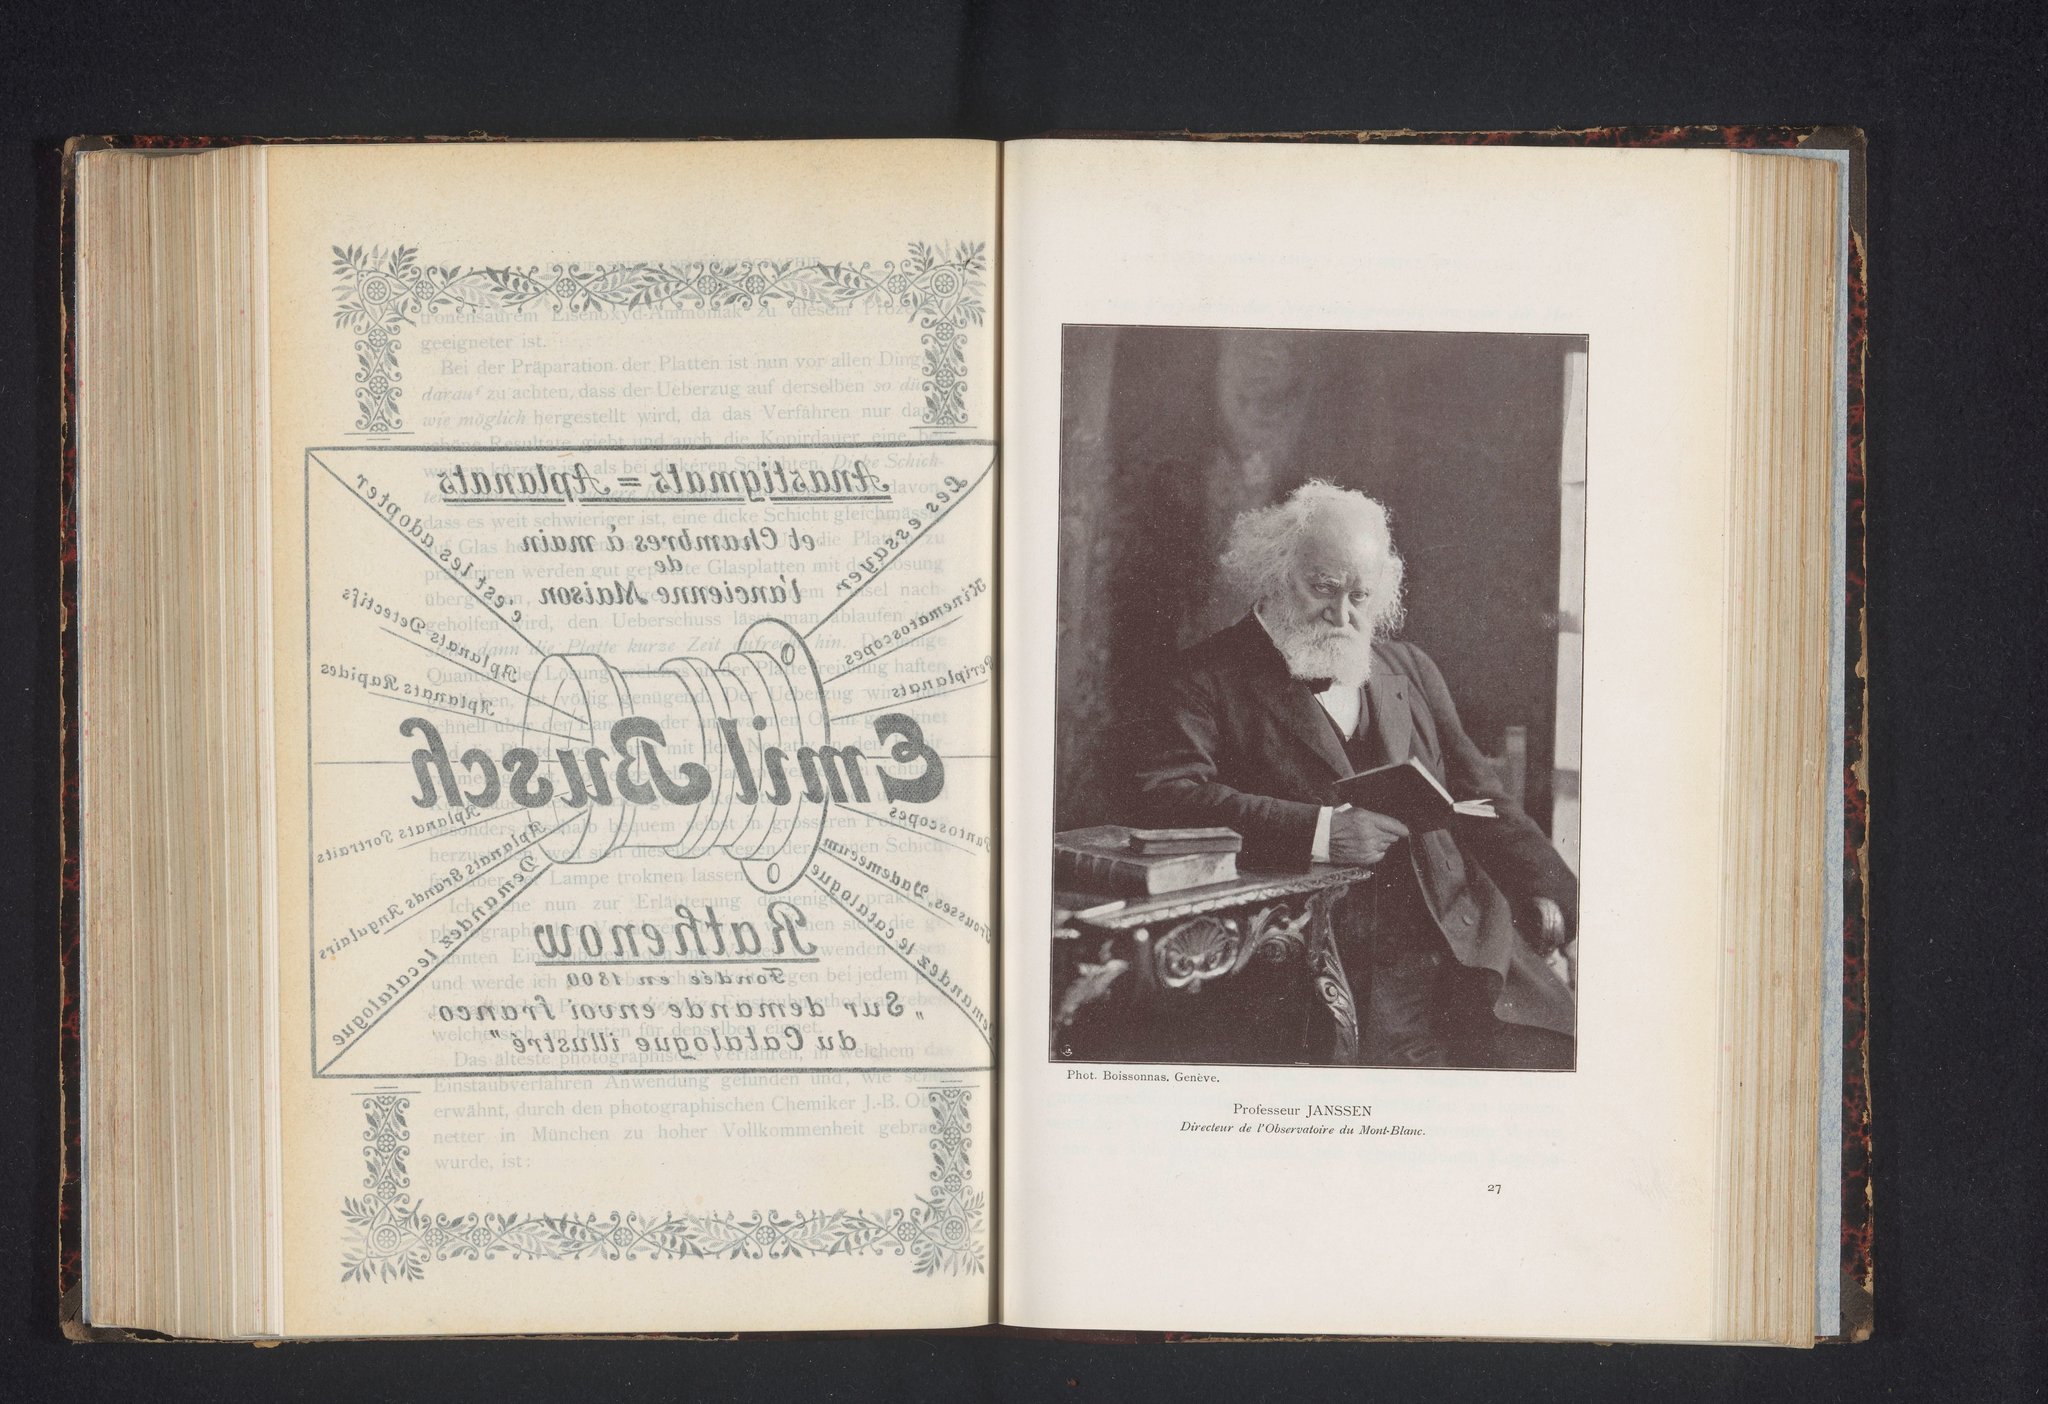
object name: page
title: Professeur Janssen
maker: frédéric boissonnas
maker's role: fotograaf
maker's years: 1858-1946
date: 1897-1902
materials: paper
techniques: autotype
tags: paris, pierre jules césar janssen, writing-table, writing-desk, sitting figure, historical persons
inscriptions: inscription: ‘Directeur de l'Observatoire du Mont-Blanc’, monogram: ‘C. Cie’